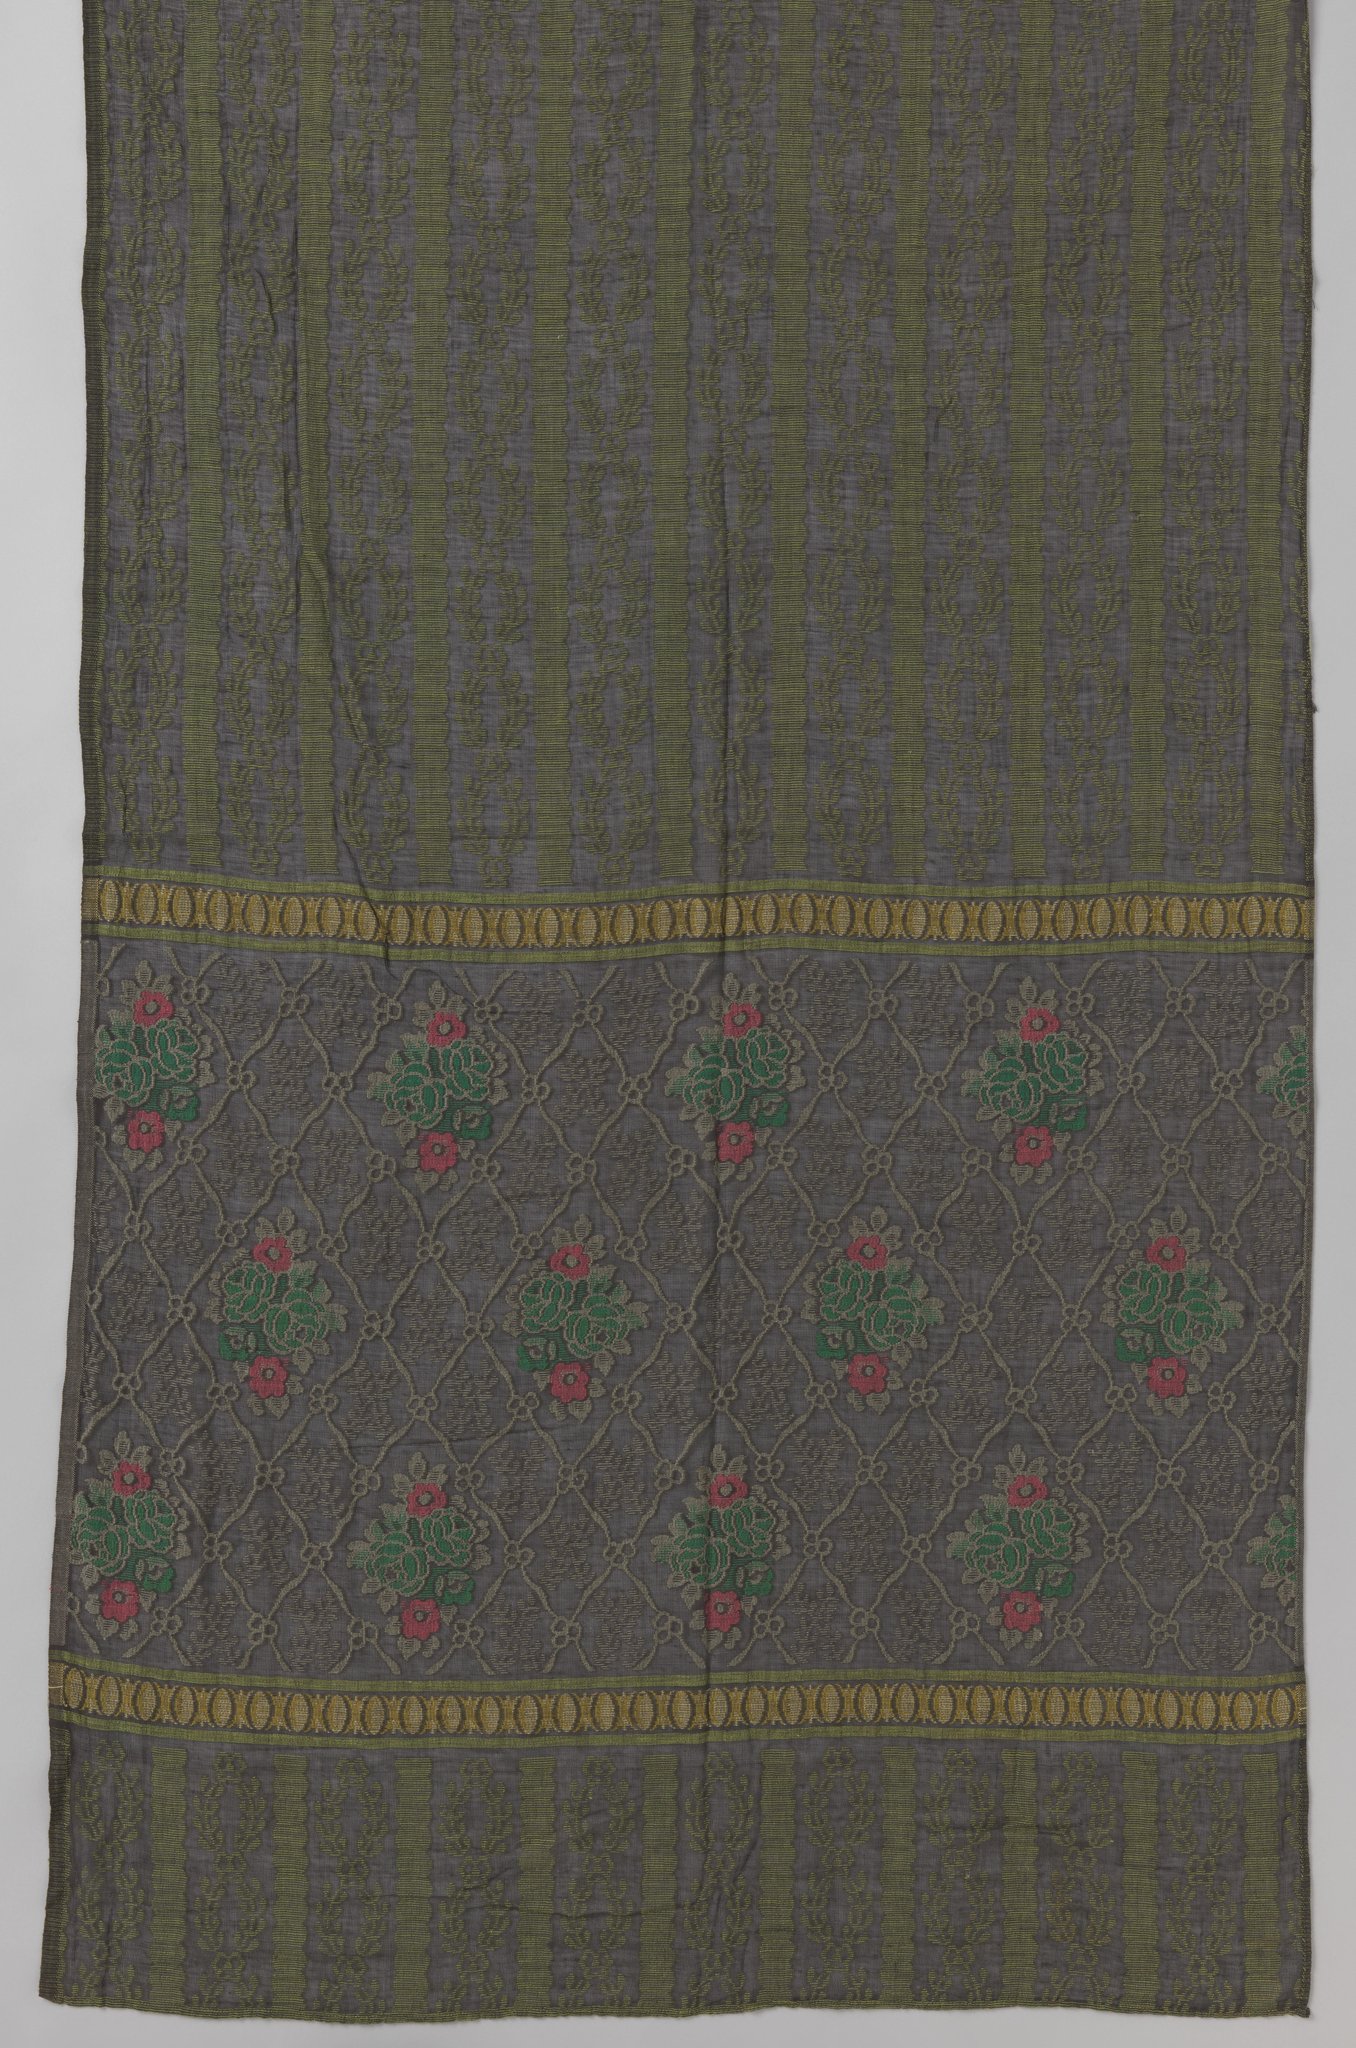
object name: curtain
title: Gordijn voor een serre in zwart gaasweefsel, patroon "Madras"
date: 1920-1930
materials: textile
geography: ghent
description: Gordijn voor een serre van madras in zwart gaasweefsel met groene verticale strepen en bladranken in ovaalvorm. Onderaan afboording in zelfde motief. Binnen een lijstornament een brede en een smalle strook groene rozen en rose bloemen tussen een ruitvormig patroon met bladranken in. Bovenaan tien ophangringen bevestigd.